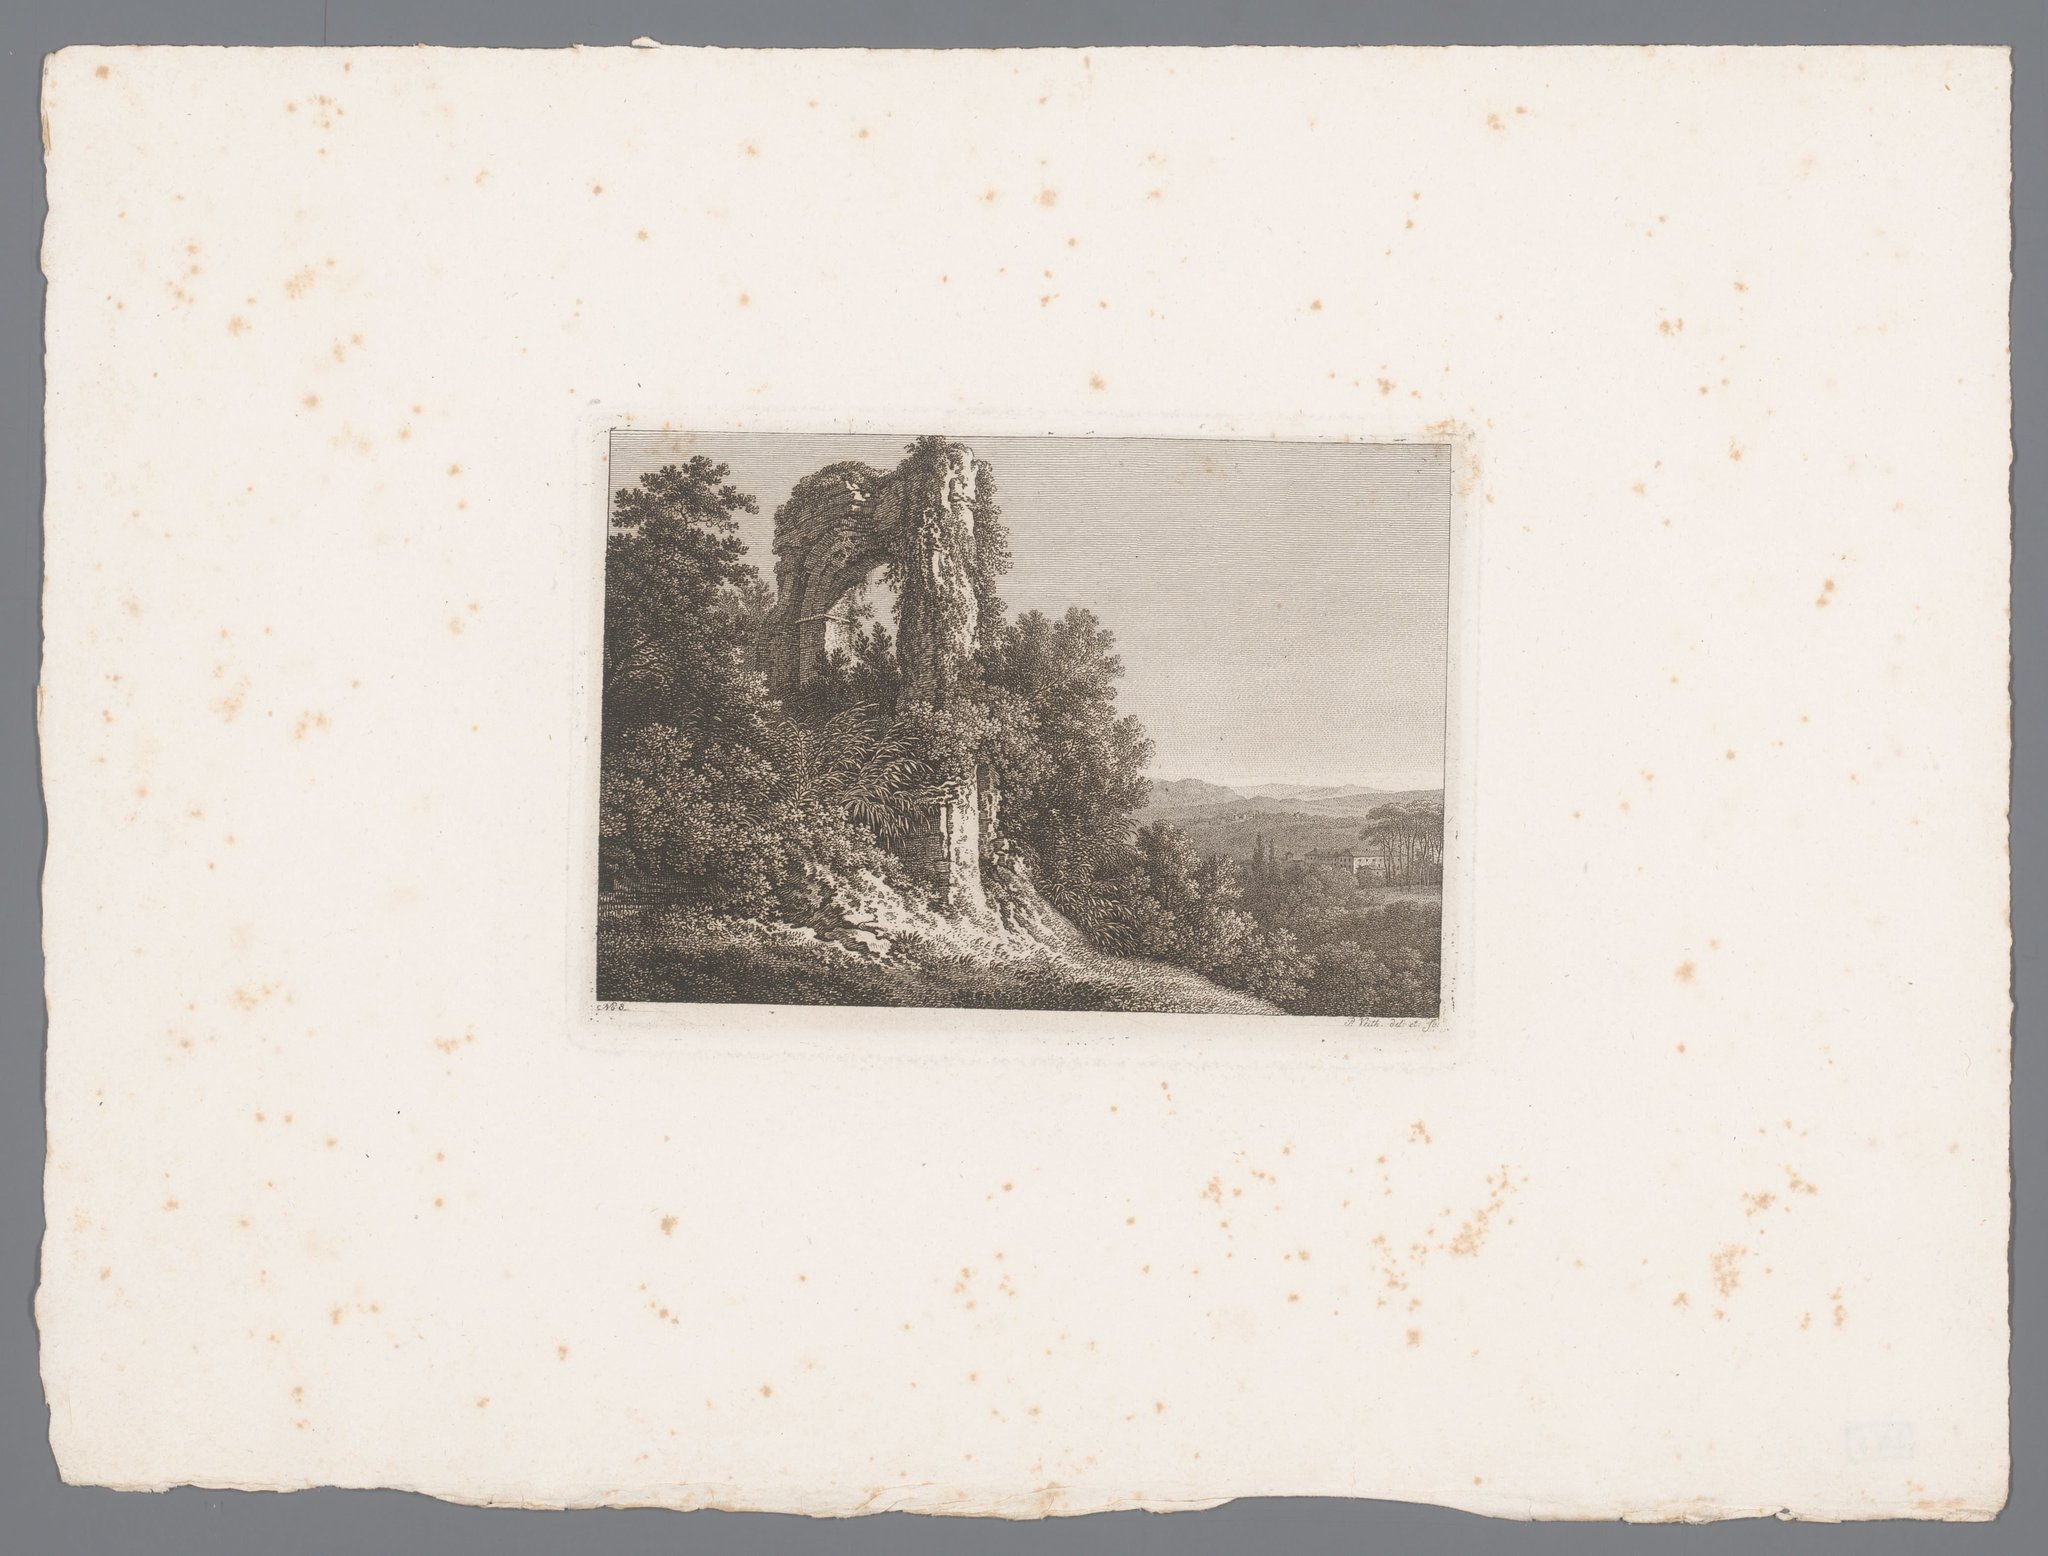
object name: print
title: Ruine in der Nähe von Rom / Ruines, des environs de Rome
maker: philipp veith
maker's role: draughtsman, print maker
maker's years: 1768-1837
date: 1822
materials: paper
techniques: etching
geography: dresden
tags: city-view, and landscape with man-made constructions, landscape with ruins, rome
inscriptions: collector's mark: Lugt 2760, collector's mark: Lugt 2228, collector's mark: Lugt 3976